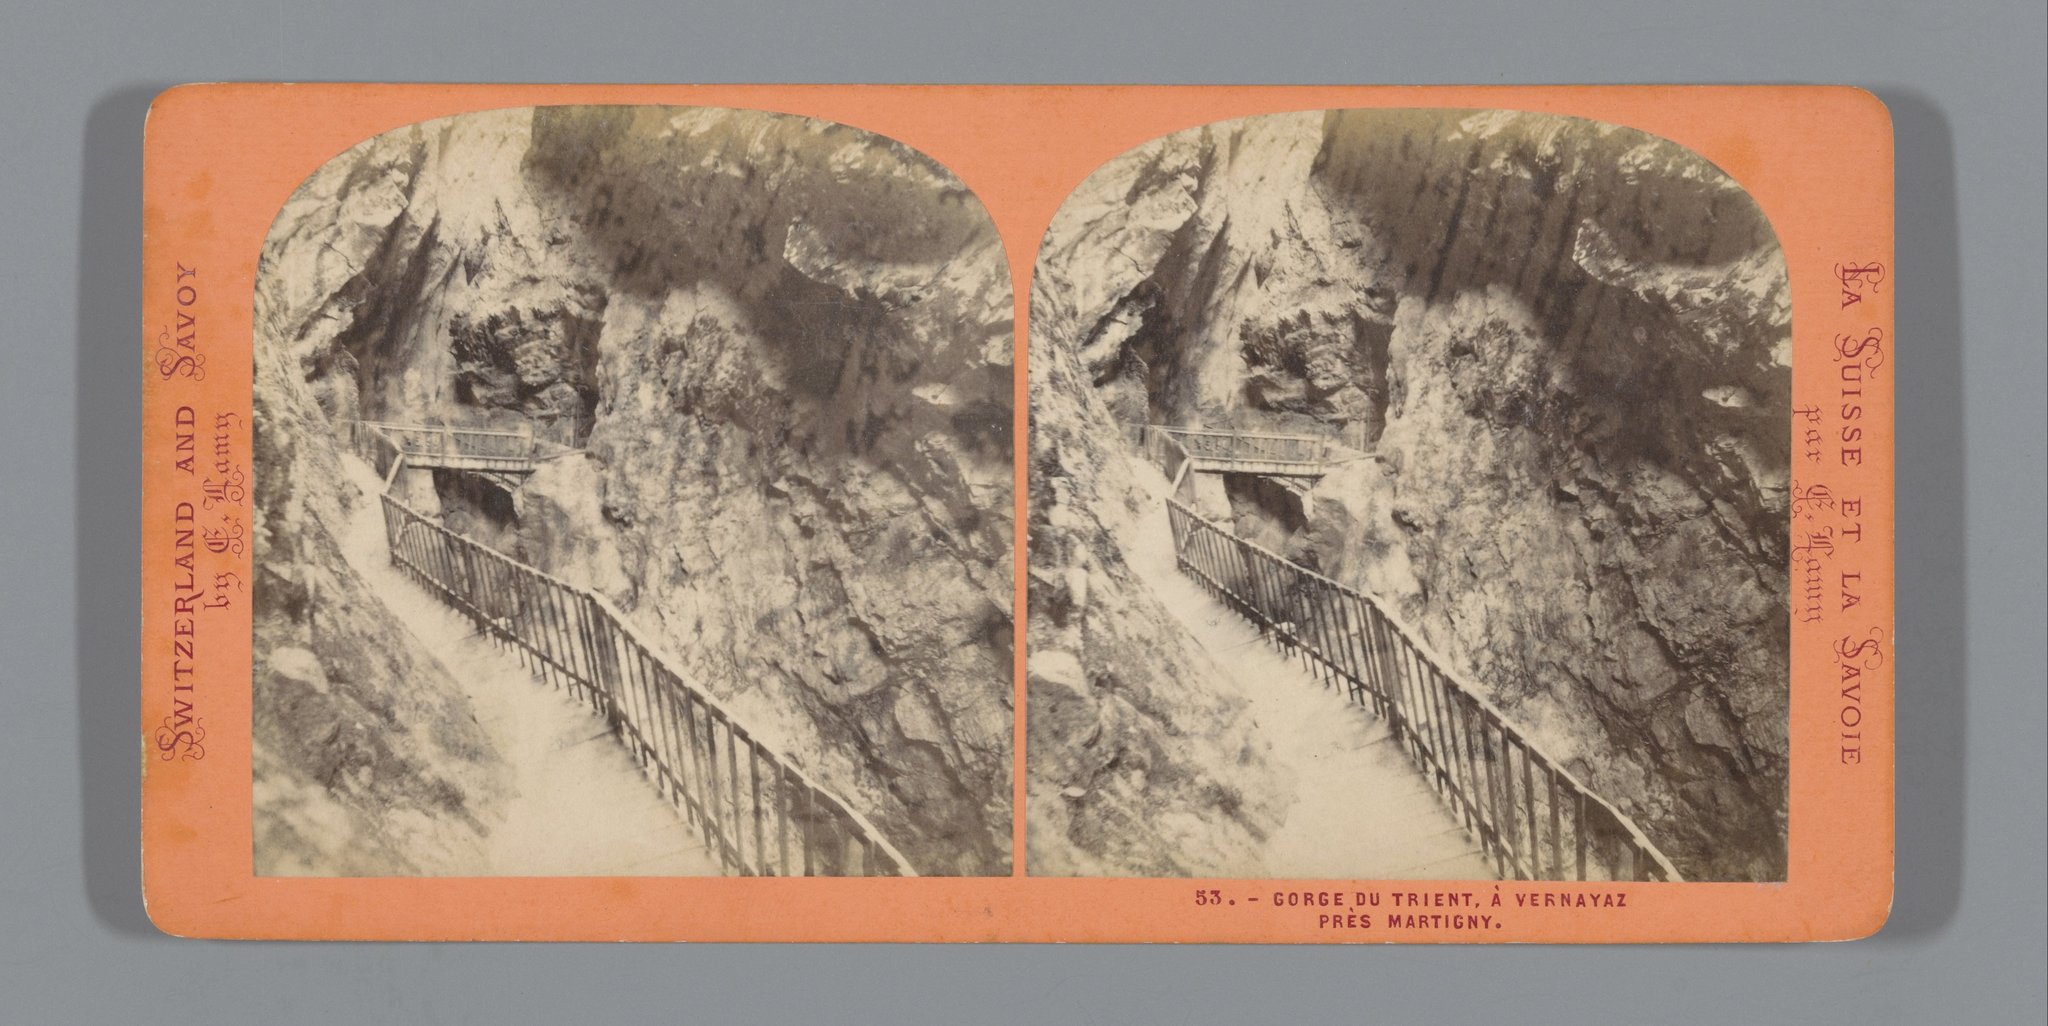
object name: stereograph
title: Looppad langs de Gorges du Trient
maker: ernest eléonor pierre lamy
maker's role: publisher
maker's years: 1828-1900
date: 1860-1880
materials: cardboard, photographic support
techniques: albumen print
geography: switzerland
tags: ravine, chasm, abyss, canyon, public road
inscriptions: number: ‘53.’